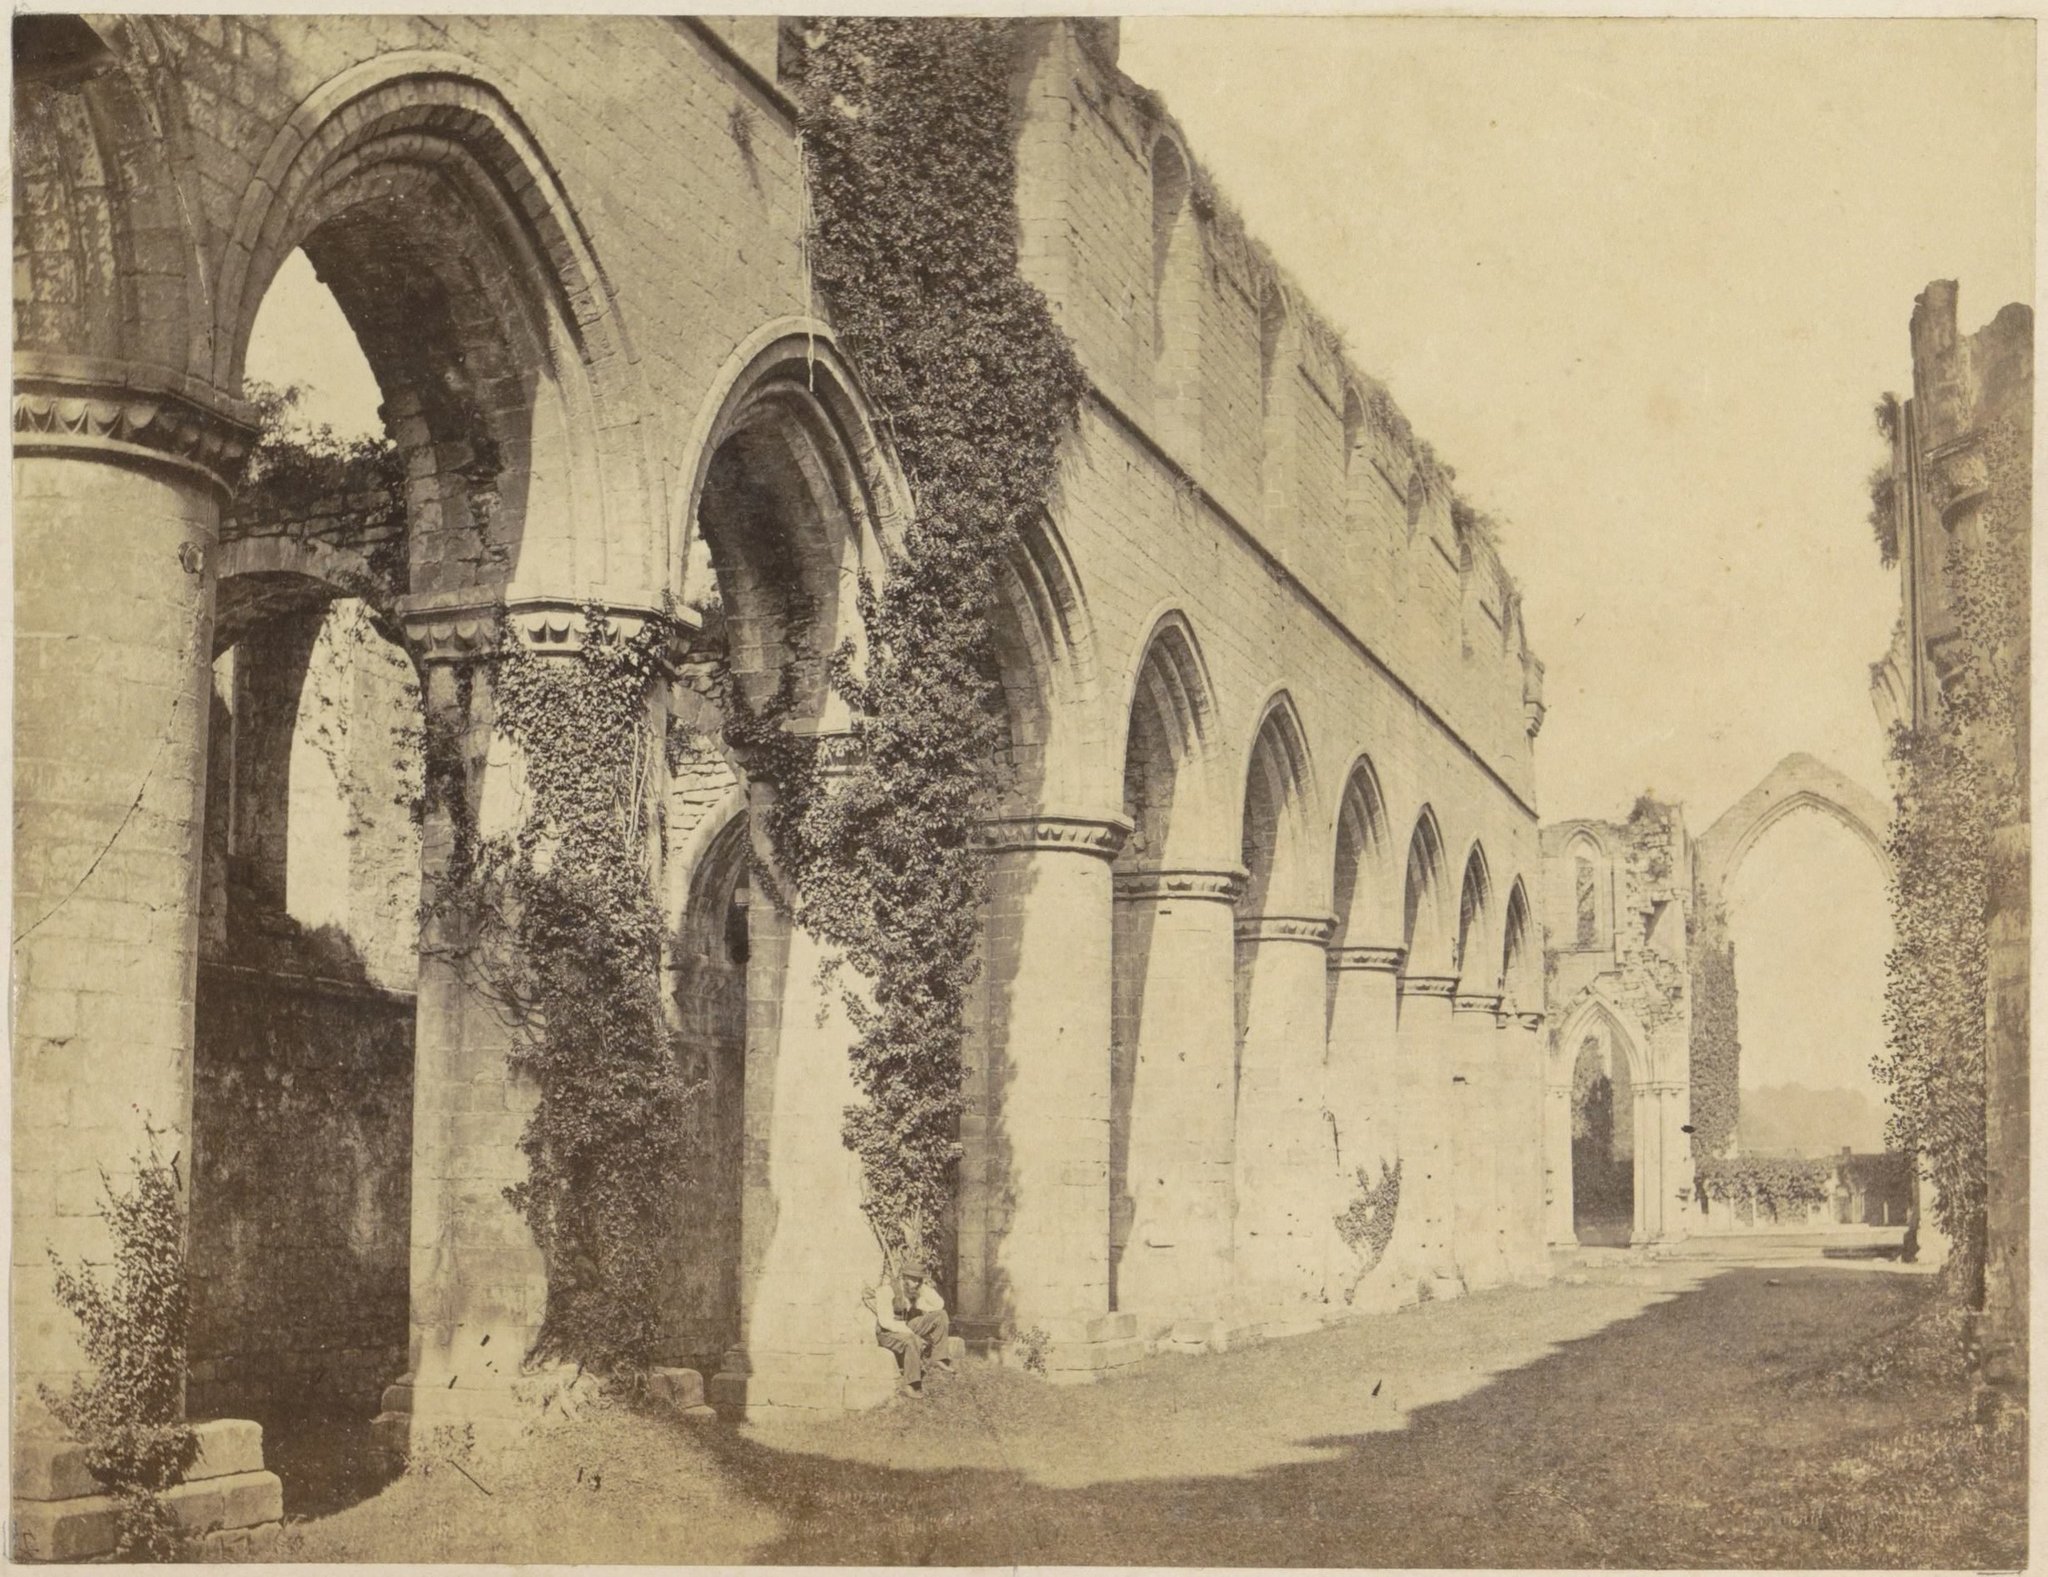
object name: photograph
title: Ruïne van een klooster in Engeland, vermoedelijk Fountains Abbey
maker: Anonymous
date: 1850-1870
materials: paper, photographic support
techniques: albumen print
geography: yorkshire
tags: parts of church interior: nave, ruin of a dwelling, house, castle, etc., england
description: Onderdeel van Album met foto's van bezienswaardigheden en landschappen in Engeland en van kunst.